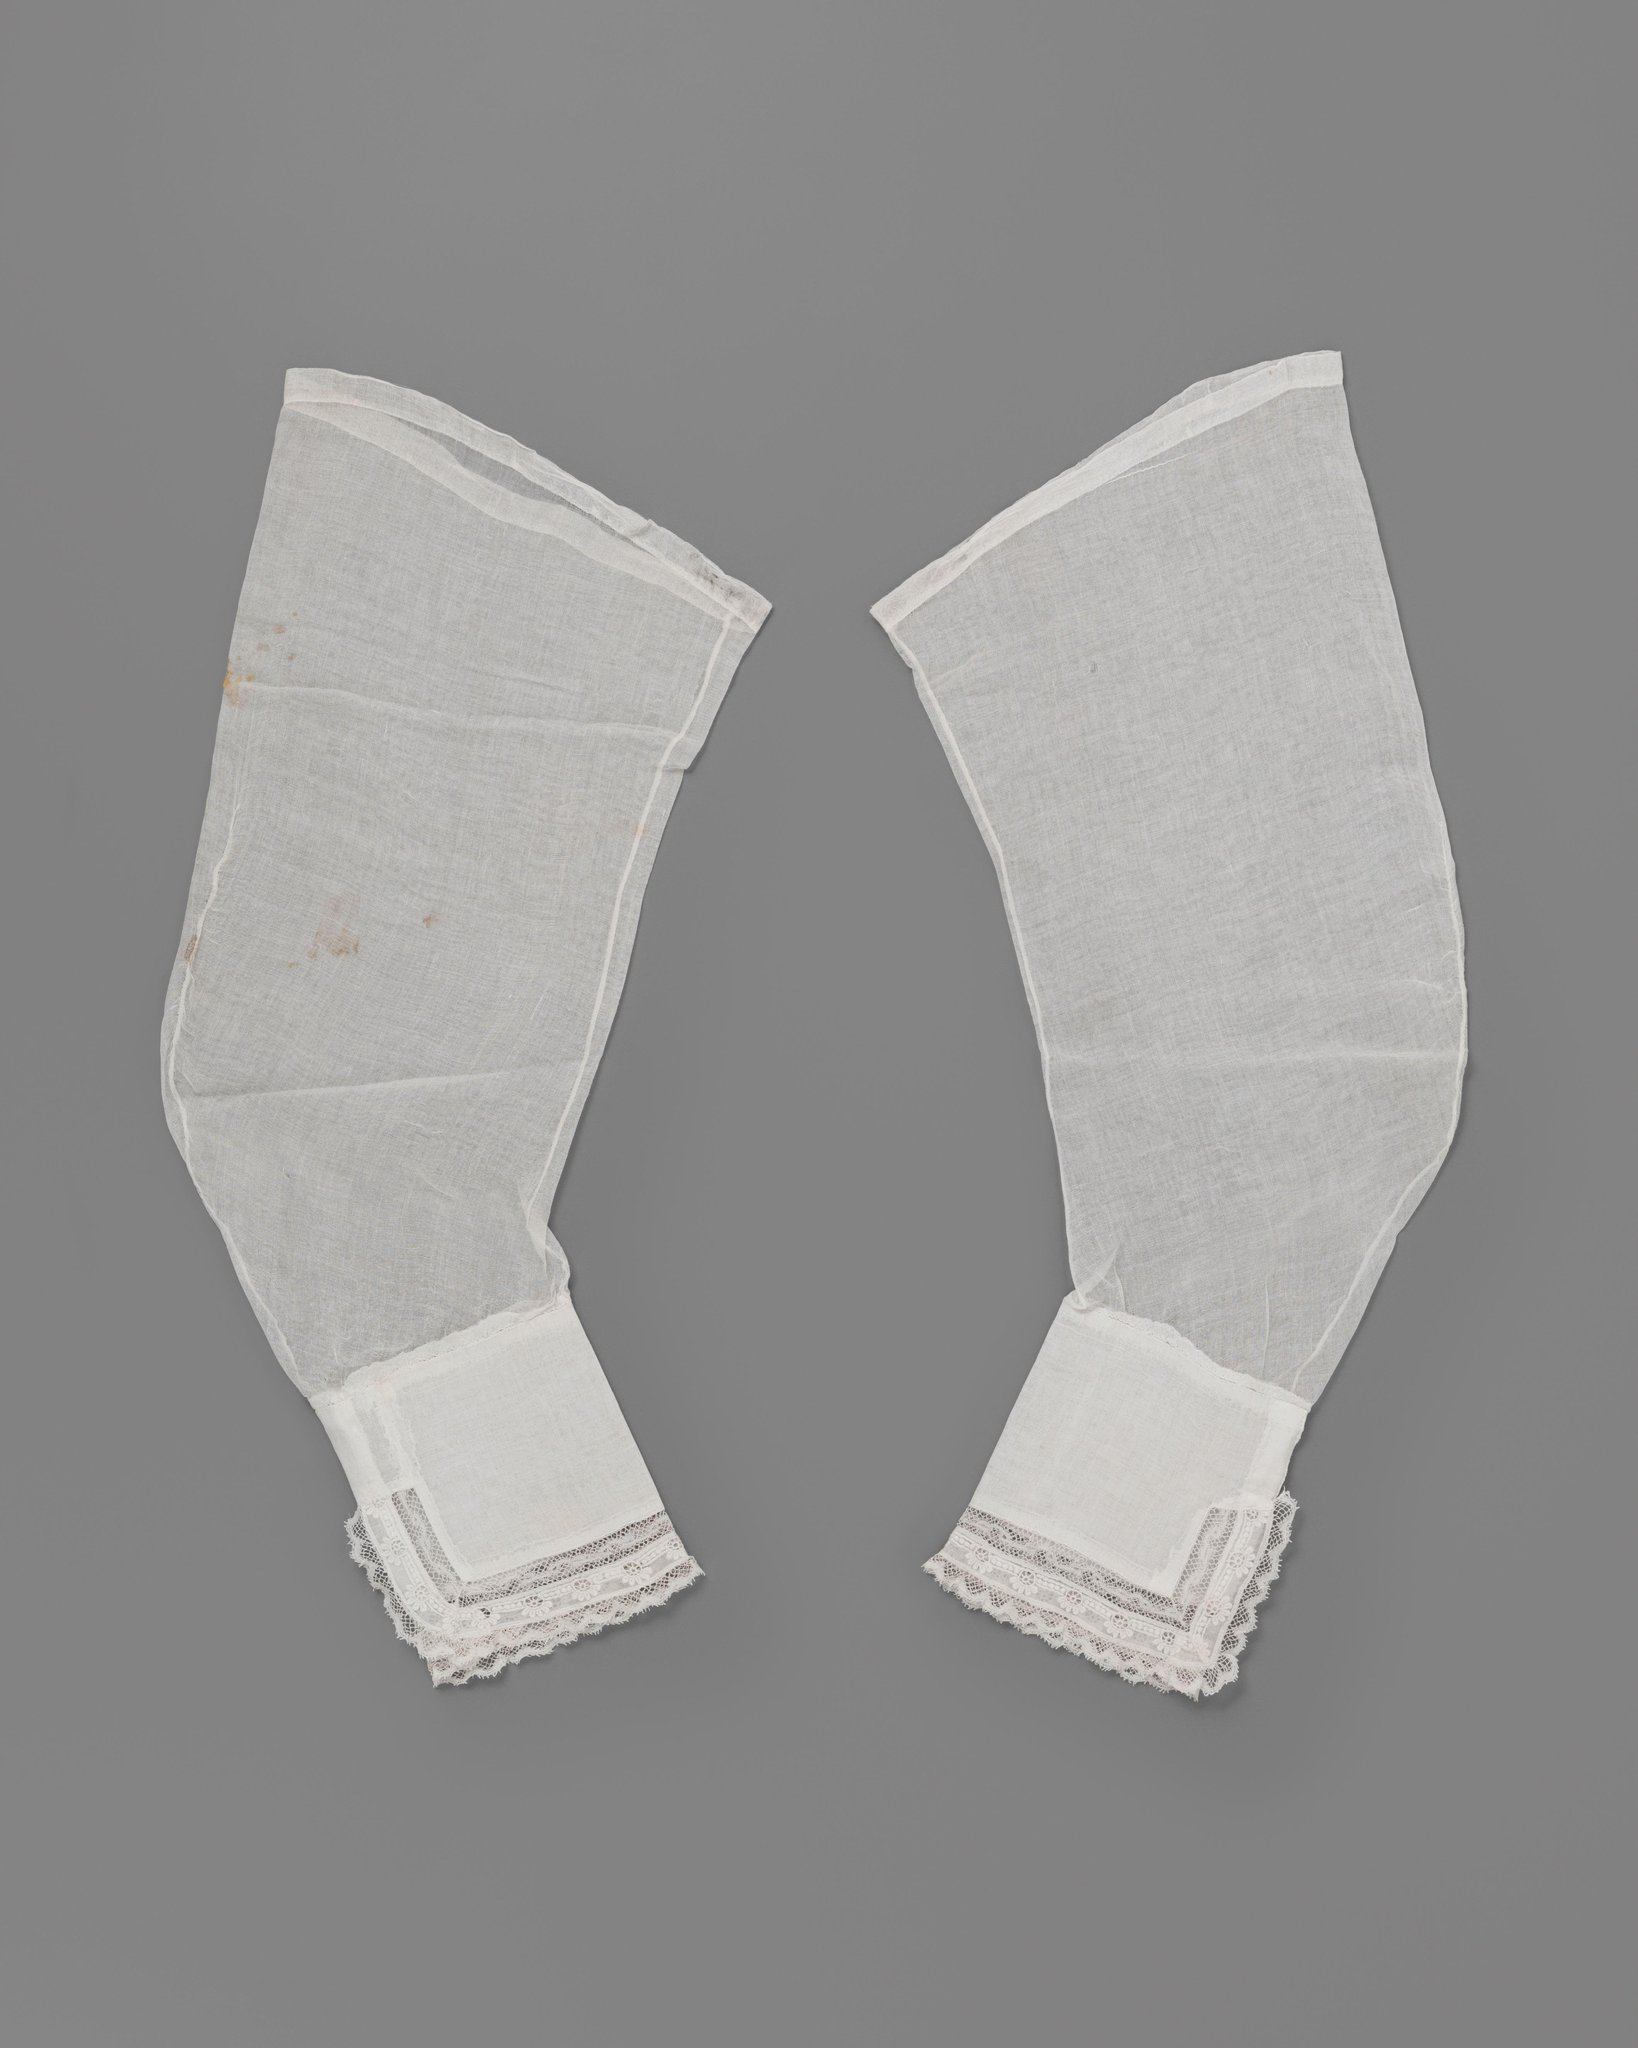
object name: womenswear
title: Ondermouw van glasbatist met een manchet die is versierd met witwerk en Valenciennes-kant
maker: Anonymous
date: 1870-1880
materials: glass batiste, lace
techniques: lace, embroidery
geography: netherlands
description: Ondermouw van glasbatist, rond gesneden. De manchet, met een overslag, heeft een met witwerk versierde entre-deux tussen een rand en een strook van Valenciennes-kant. Het witwerk heeft de vorm van een parelrand die wordt onderbroken door wielen.Ondermouw van glasbatist met een manchet die is versierd met witwerk en kant